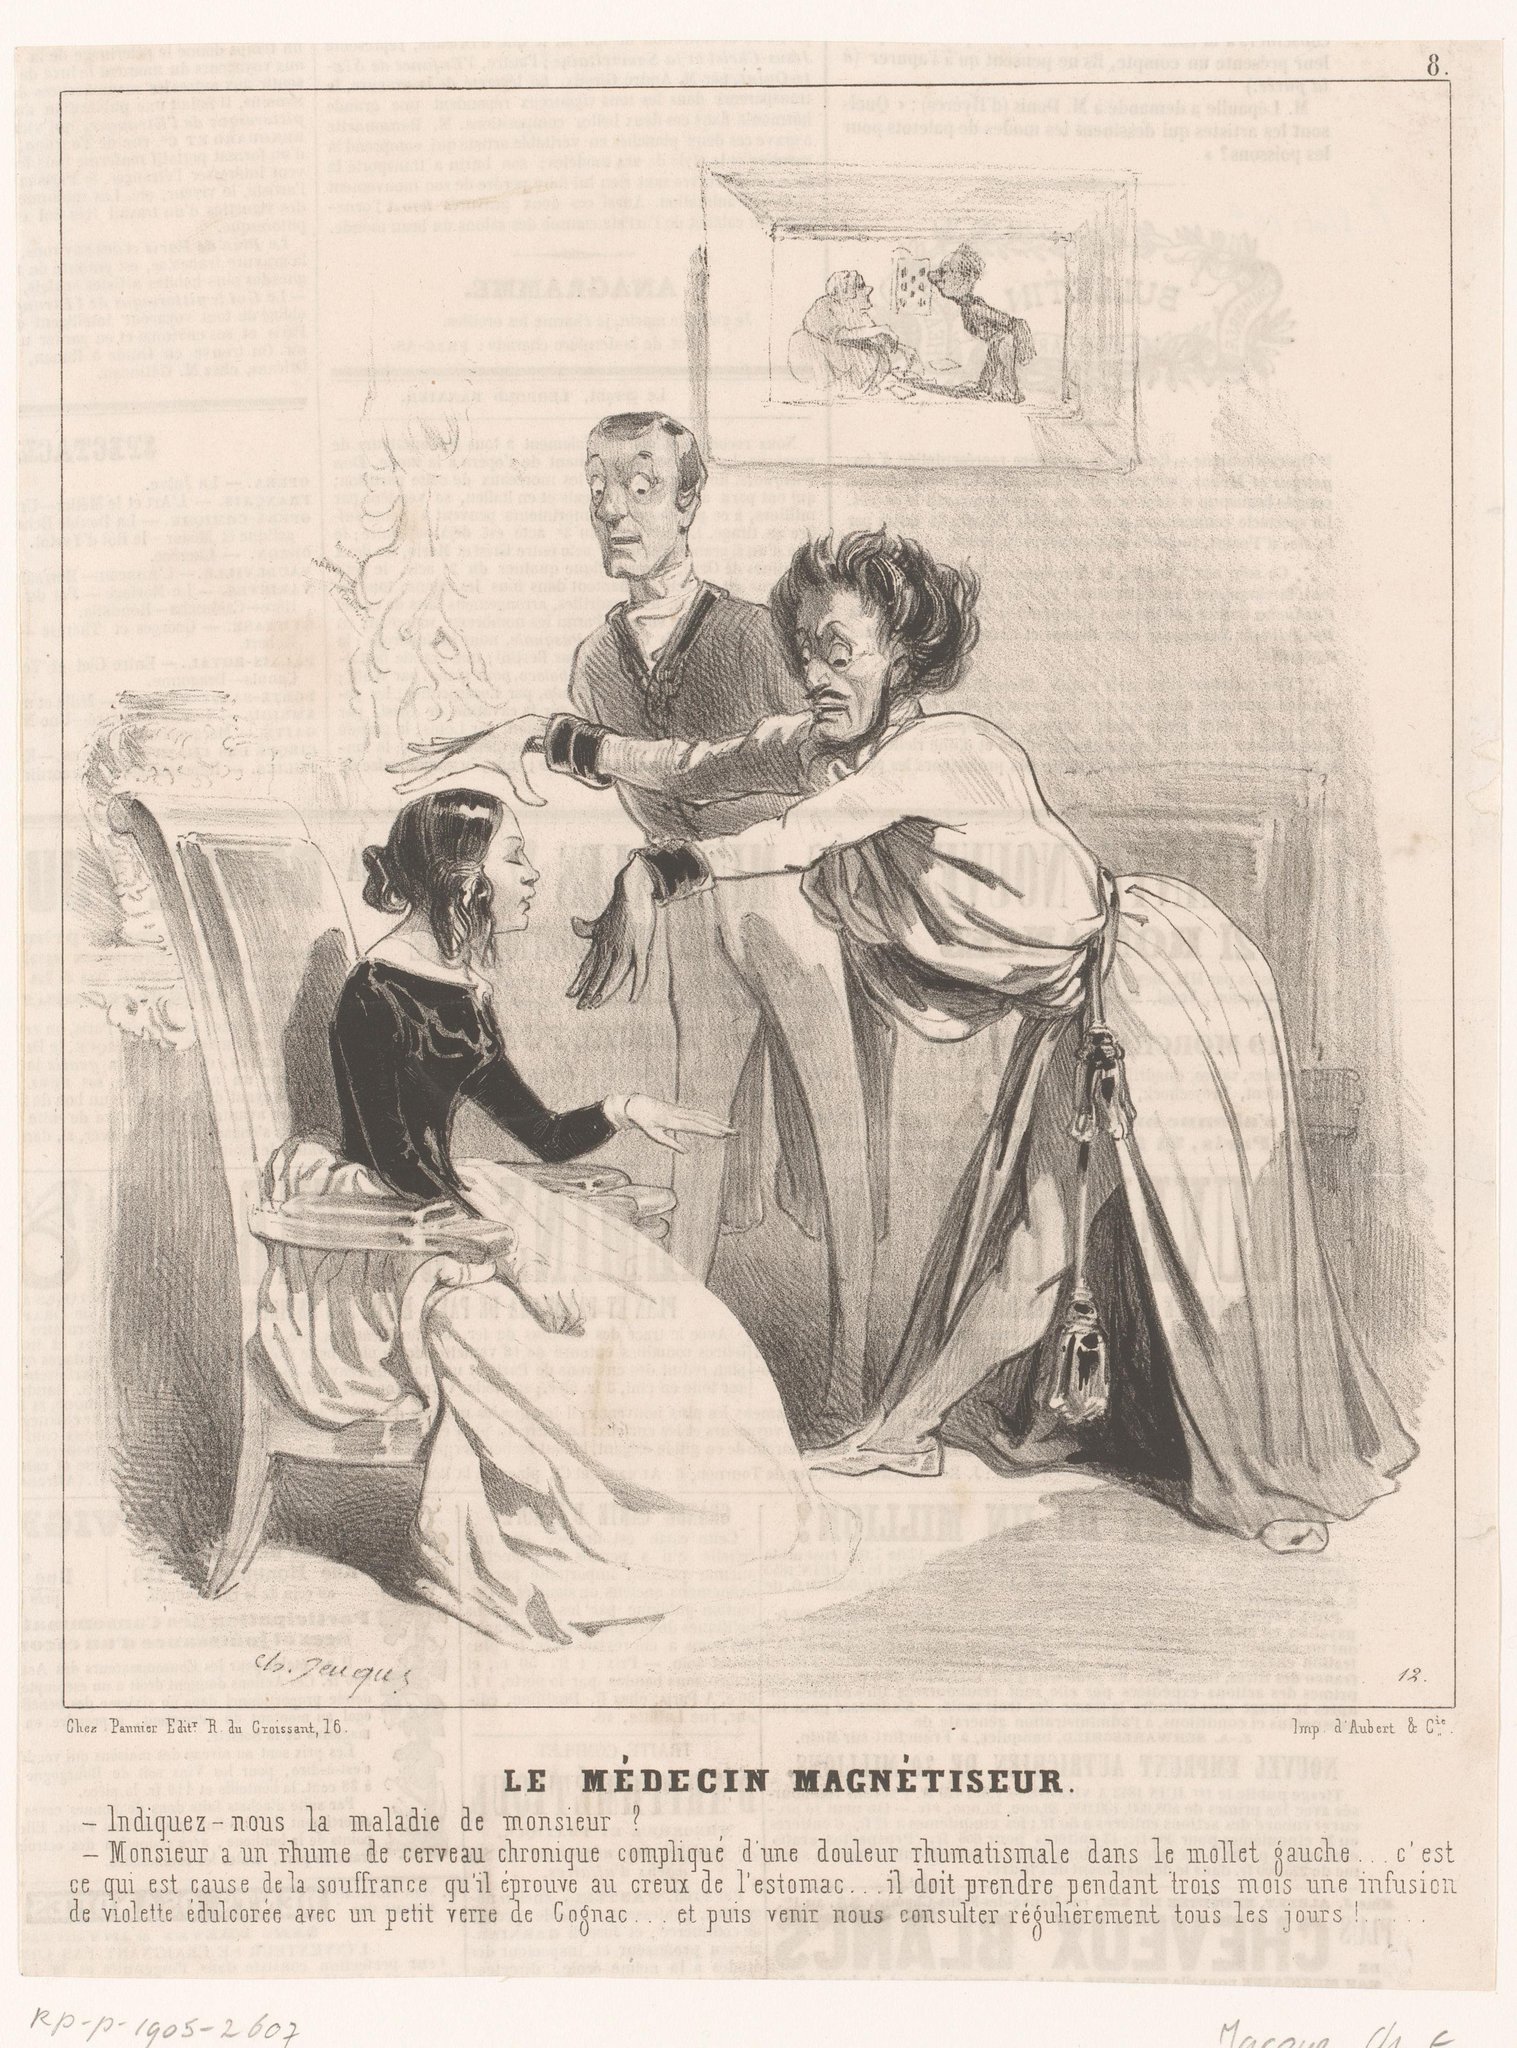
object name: print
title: Les malades et les médecins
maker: charles emile jacque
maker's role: draughtsman, painter, print maker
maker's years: 1813-1894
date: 1843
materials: paper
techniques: lithograph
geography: paris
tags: caricatures (human types), quack, charlatan, mountebank, 'saltimbanco', physician, doctor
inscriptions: collector's mark: Lugt 2228a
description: Prent gebruikt voor: Le Charivari, 1843.